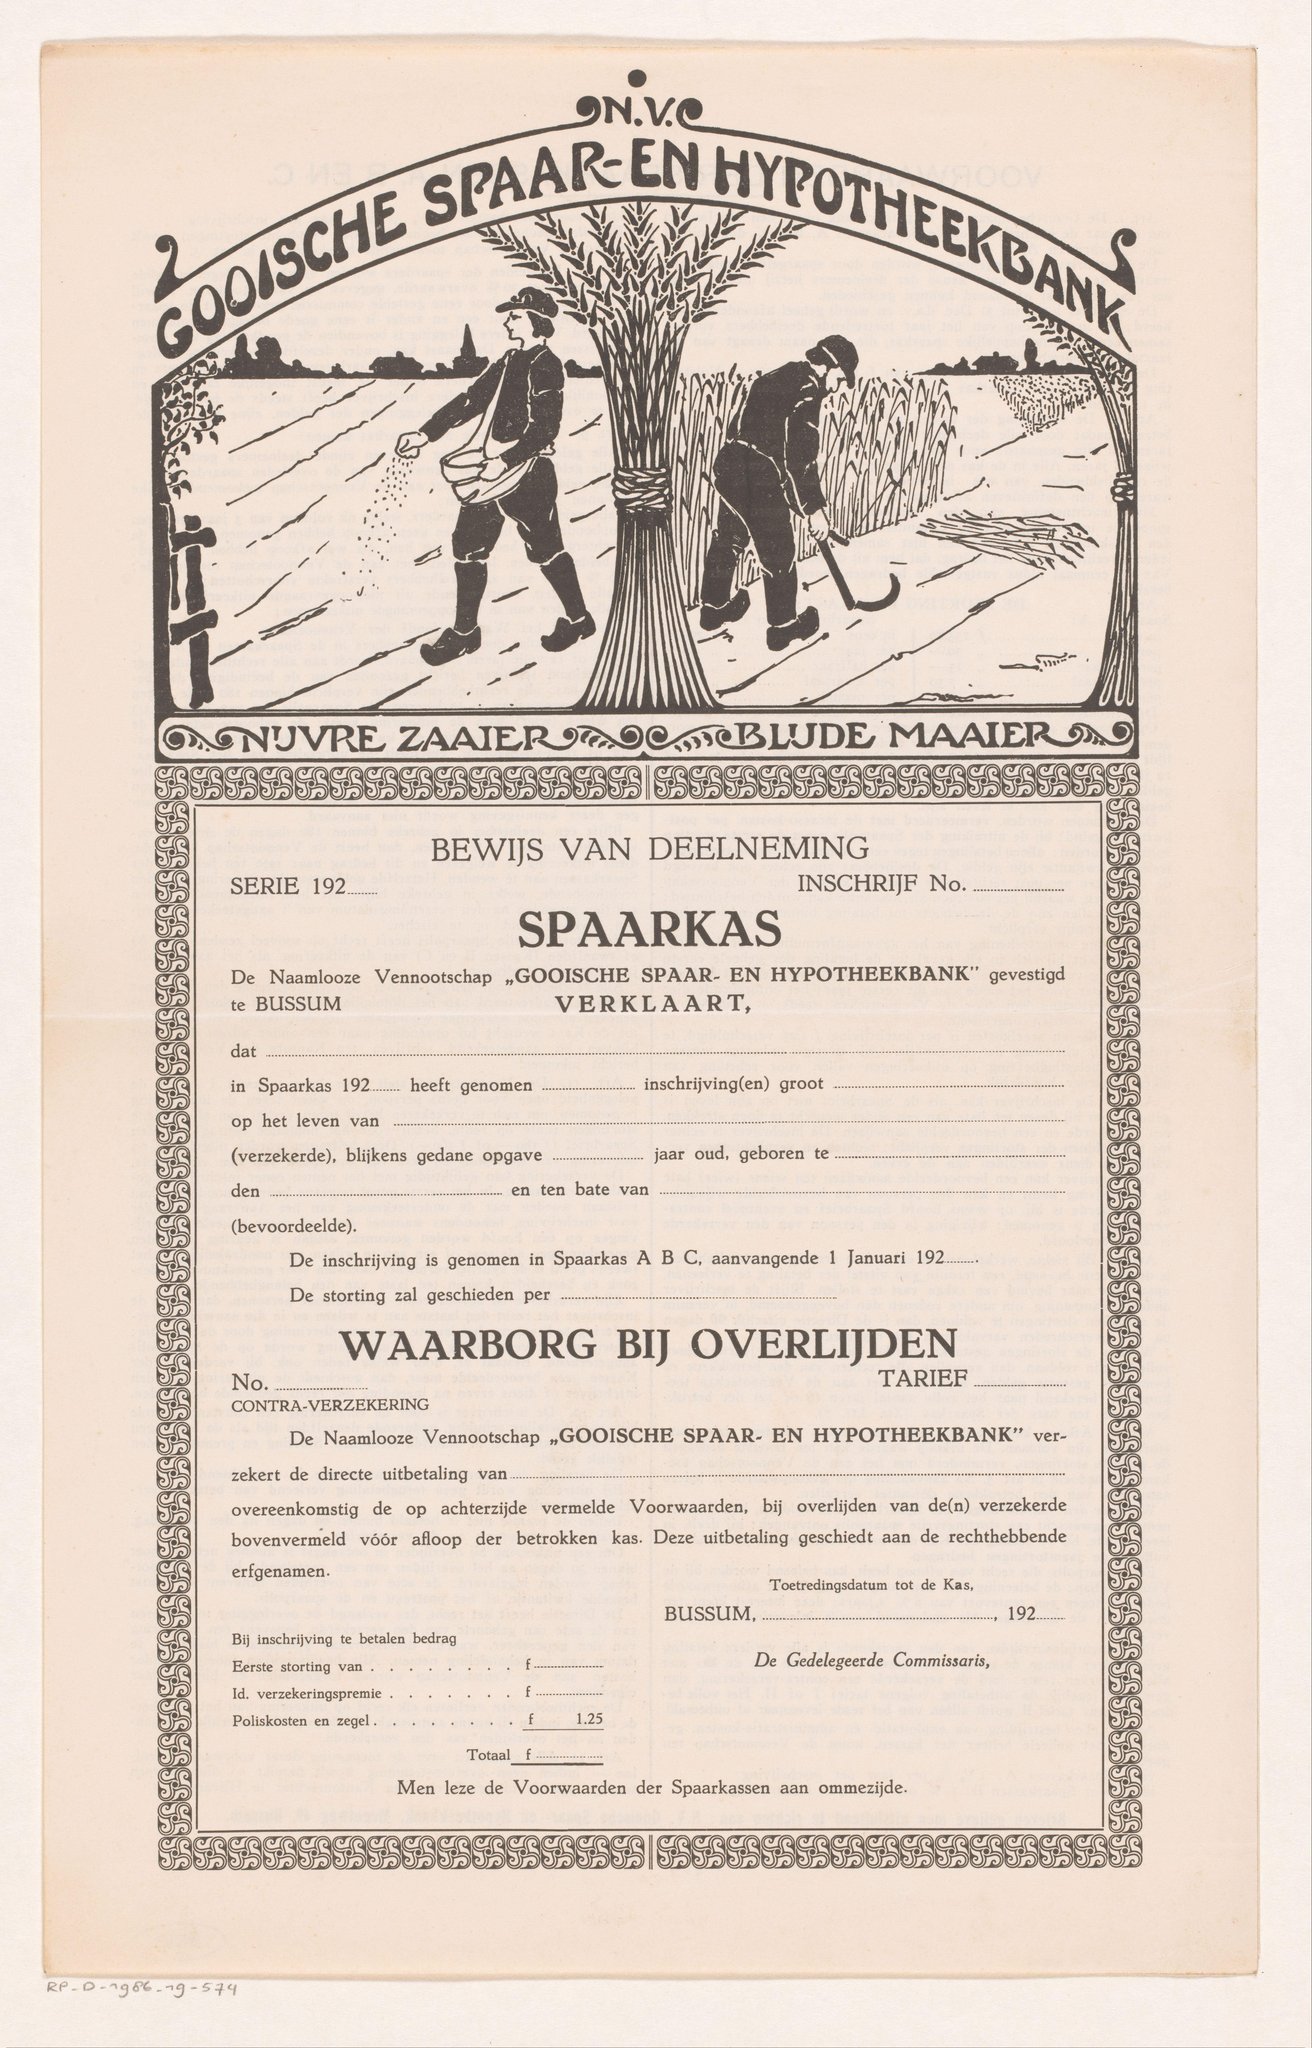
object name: photomechanical print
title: Nijvre zaaier blijde maaier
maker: reinier willem petrus de vries (1874-1953)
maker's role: draughtsman, print maker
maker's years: 1874-1953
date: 1920-1929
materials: paper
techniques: printing block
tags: sowing, reaping, picking, mowing ~ harvest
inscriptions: annotation: ‘De faba. Basel/ {...]mma [...]48’, collector's mark: ‘R:MVS.’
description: Bewijs van deelneming met bovenaan een kader. Links in het kader zaait een man in een veld en rechts maait hij zijn oogst. Een bundel koren scheidt de twee voorstellingen.